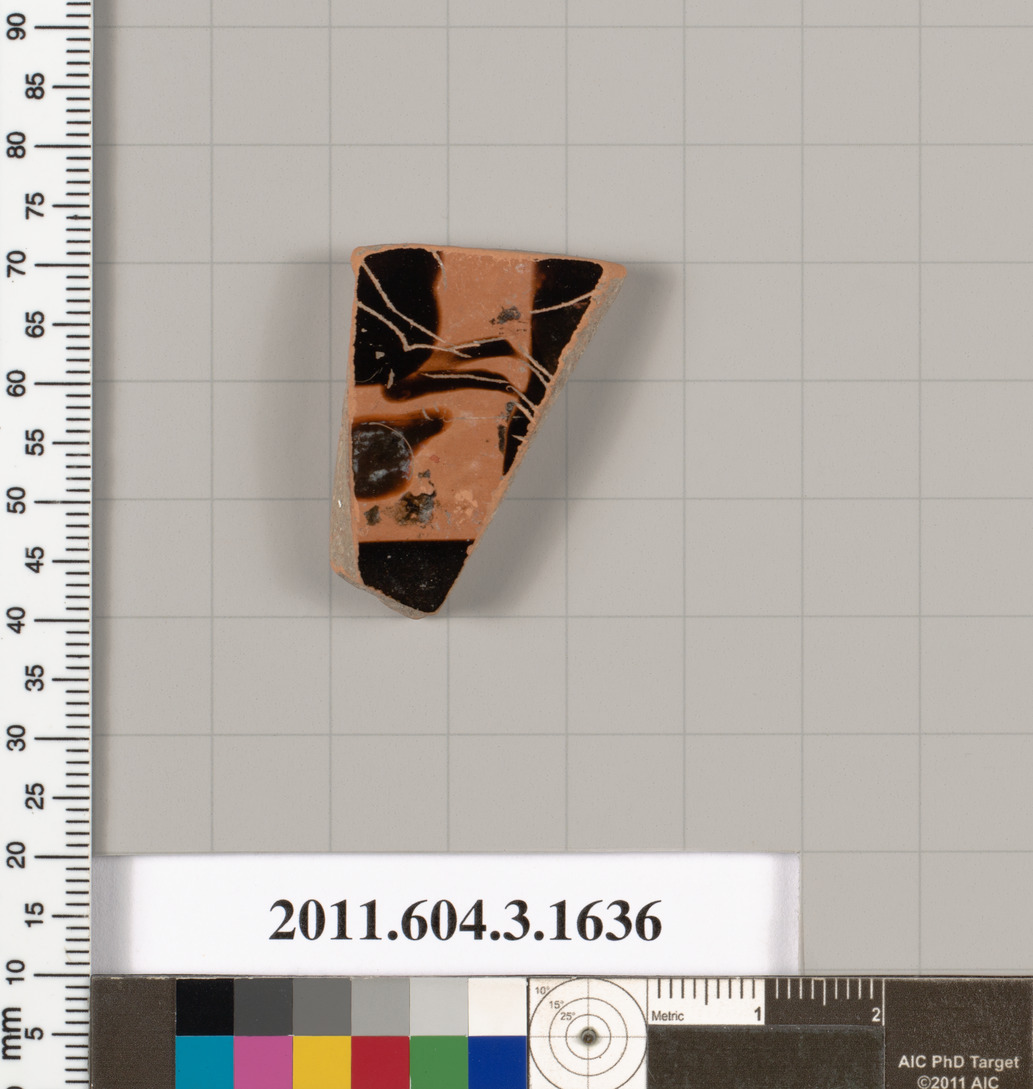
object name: kylix fragment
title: Terracotta fragment of a kylix: Band cup (drinking cup)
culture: greek, attic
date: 550-526 BCE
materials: terracotta